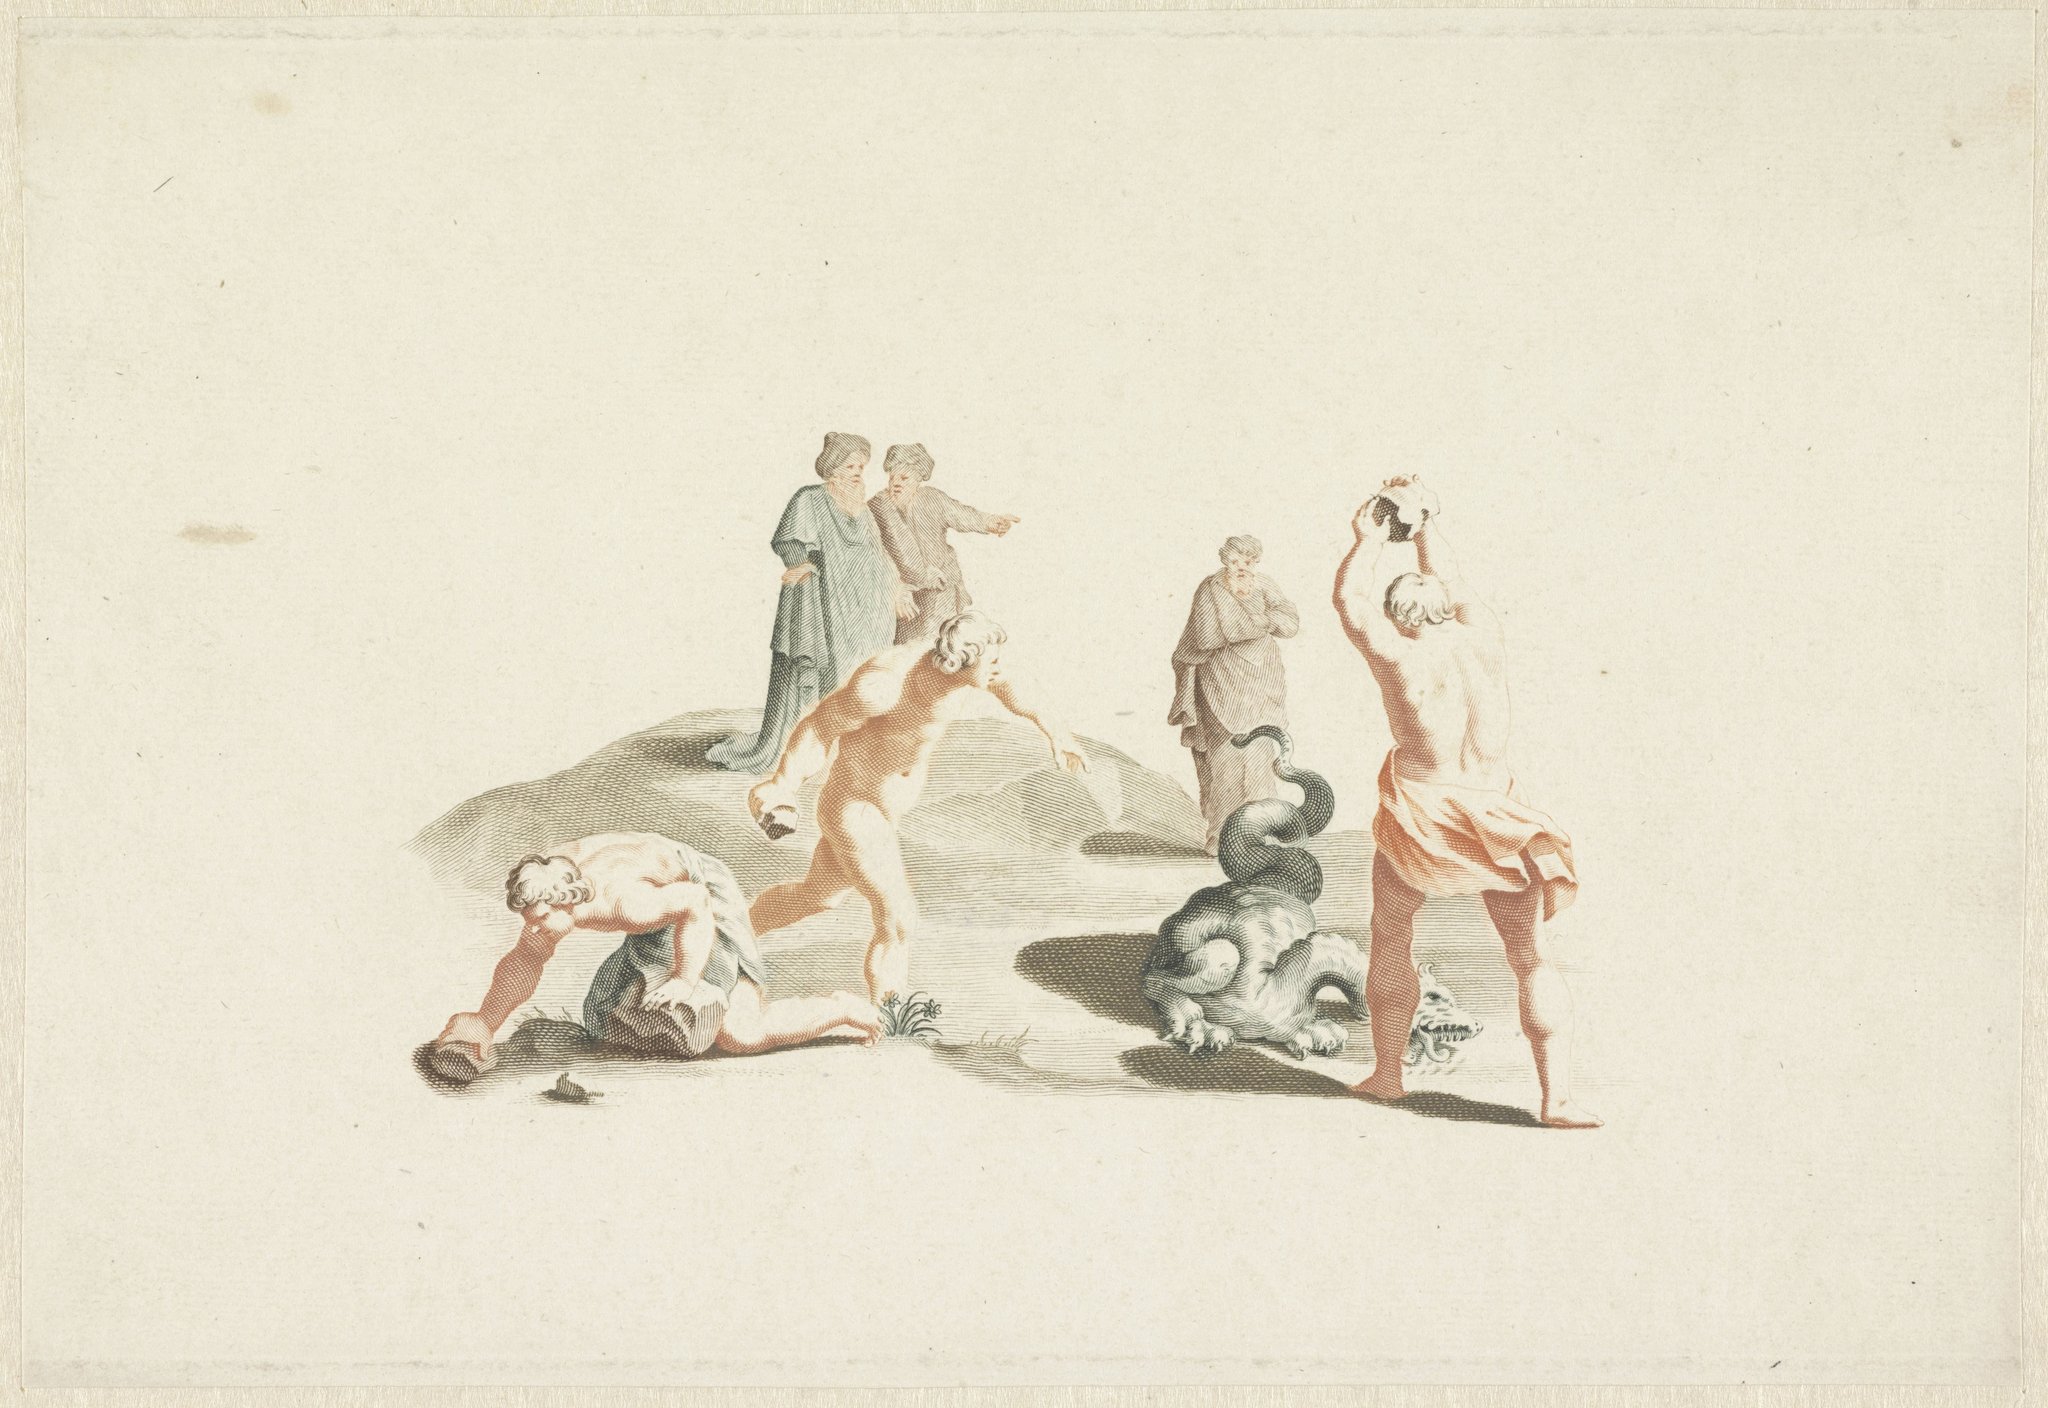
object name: print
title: Drie mannen stenigen een draak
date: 1688-1698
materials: paper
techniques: printing, engraving, lithography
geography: netherlands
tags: dragon (+ animal killed by man)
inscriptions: collector's mark: Lugt 2228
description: Drie mannen stenigen een draak, terwijl drie geklede mannen toekijken.